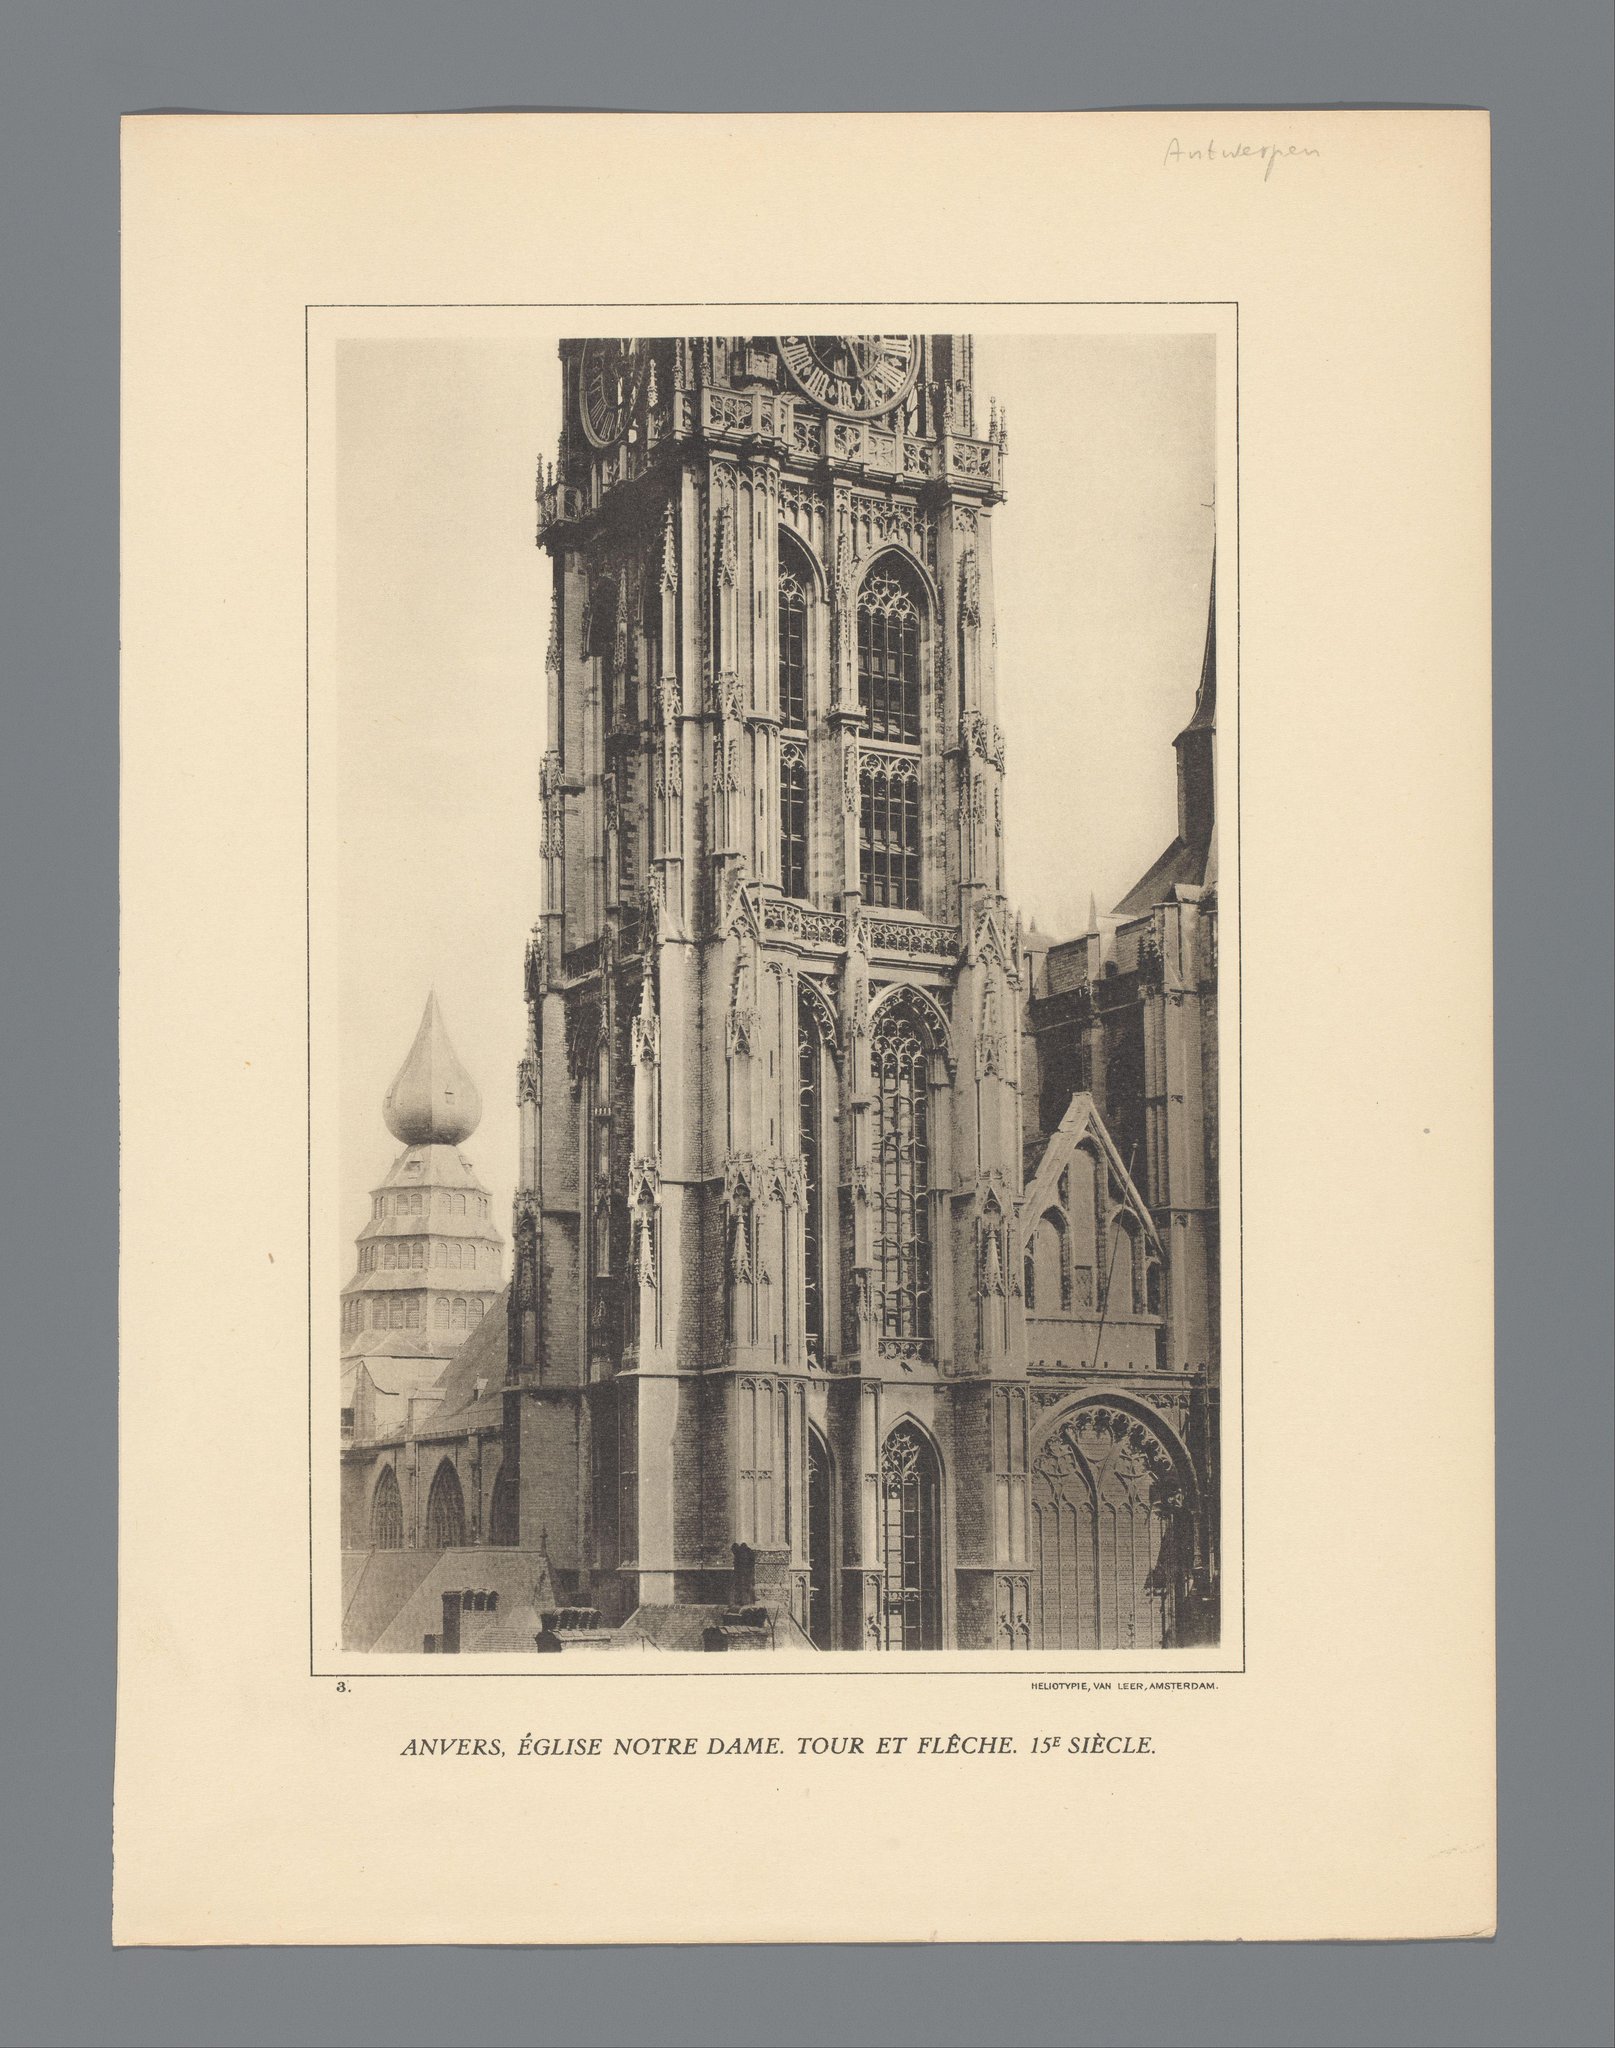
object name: photograph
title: Église Notre Dame. Tour et flêche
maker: Anonymous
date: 1860-1925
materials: photographic support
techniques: photograph